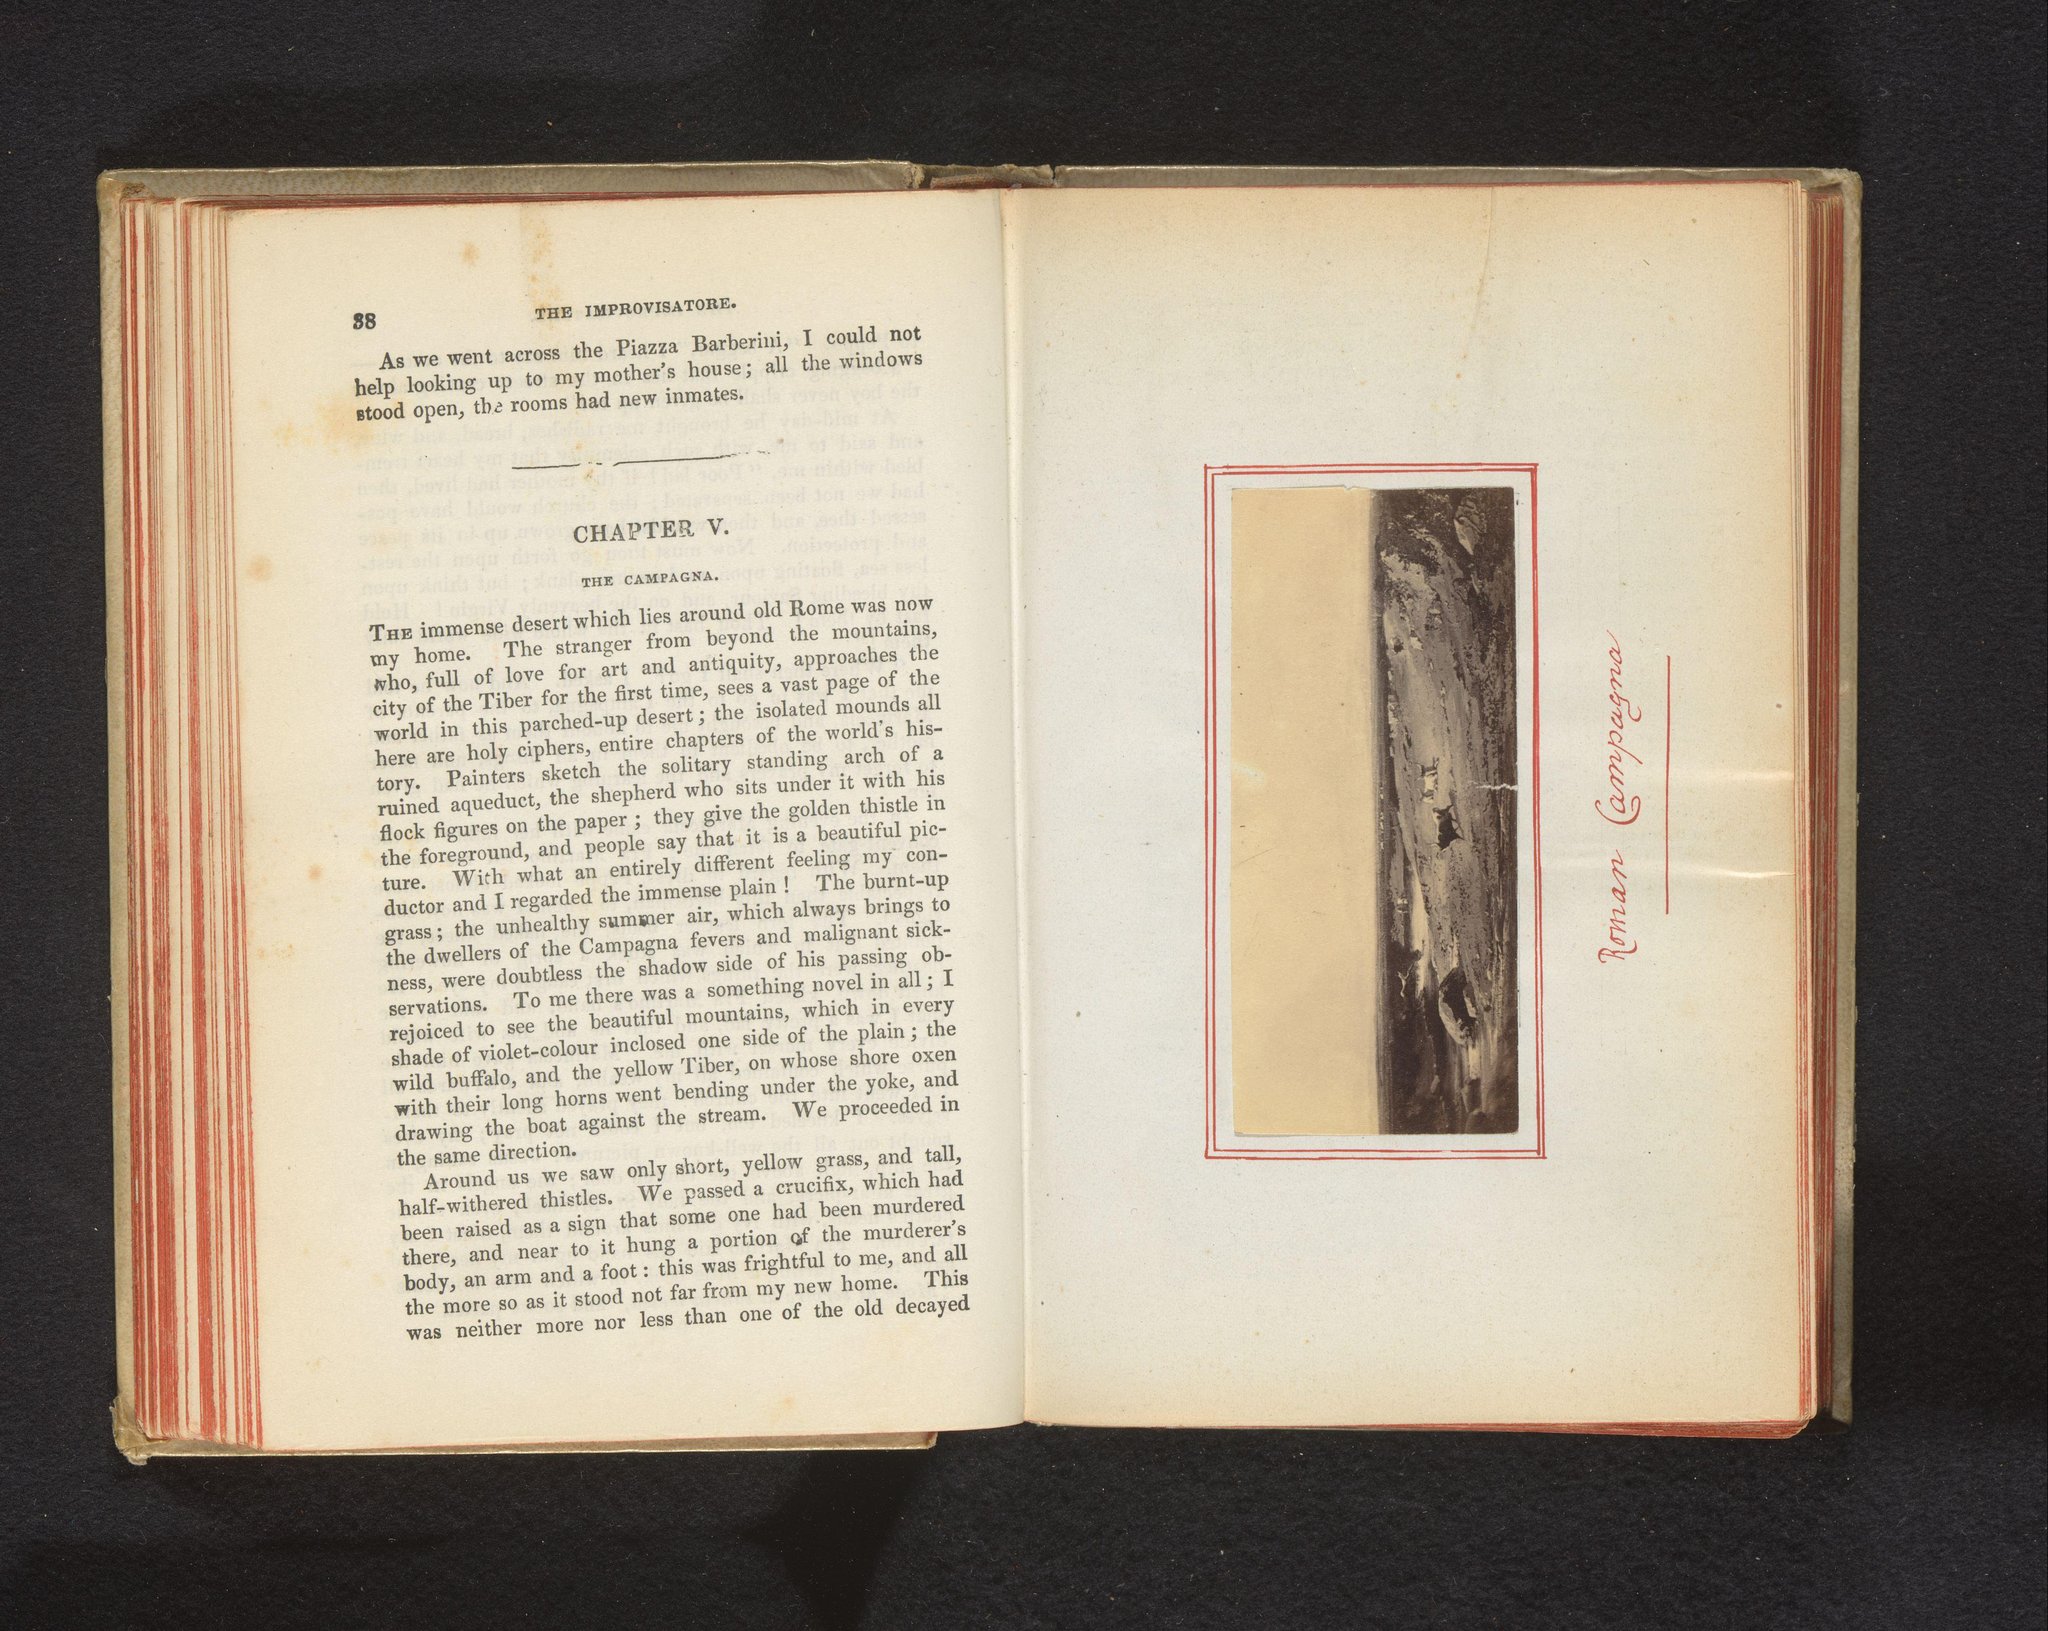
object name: reproduction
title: Roman campagna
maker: Anonymous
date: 1863-1873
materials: photographic support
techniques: albumen print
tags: meadow, pasture, bovine cattle